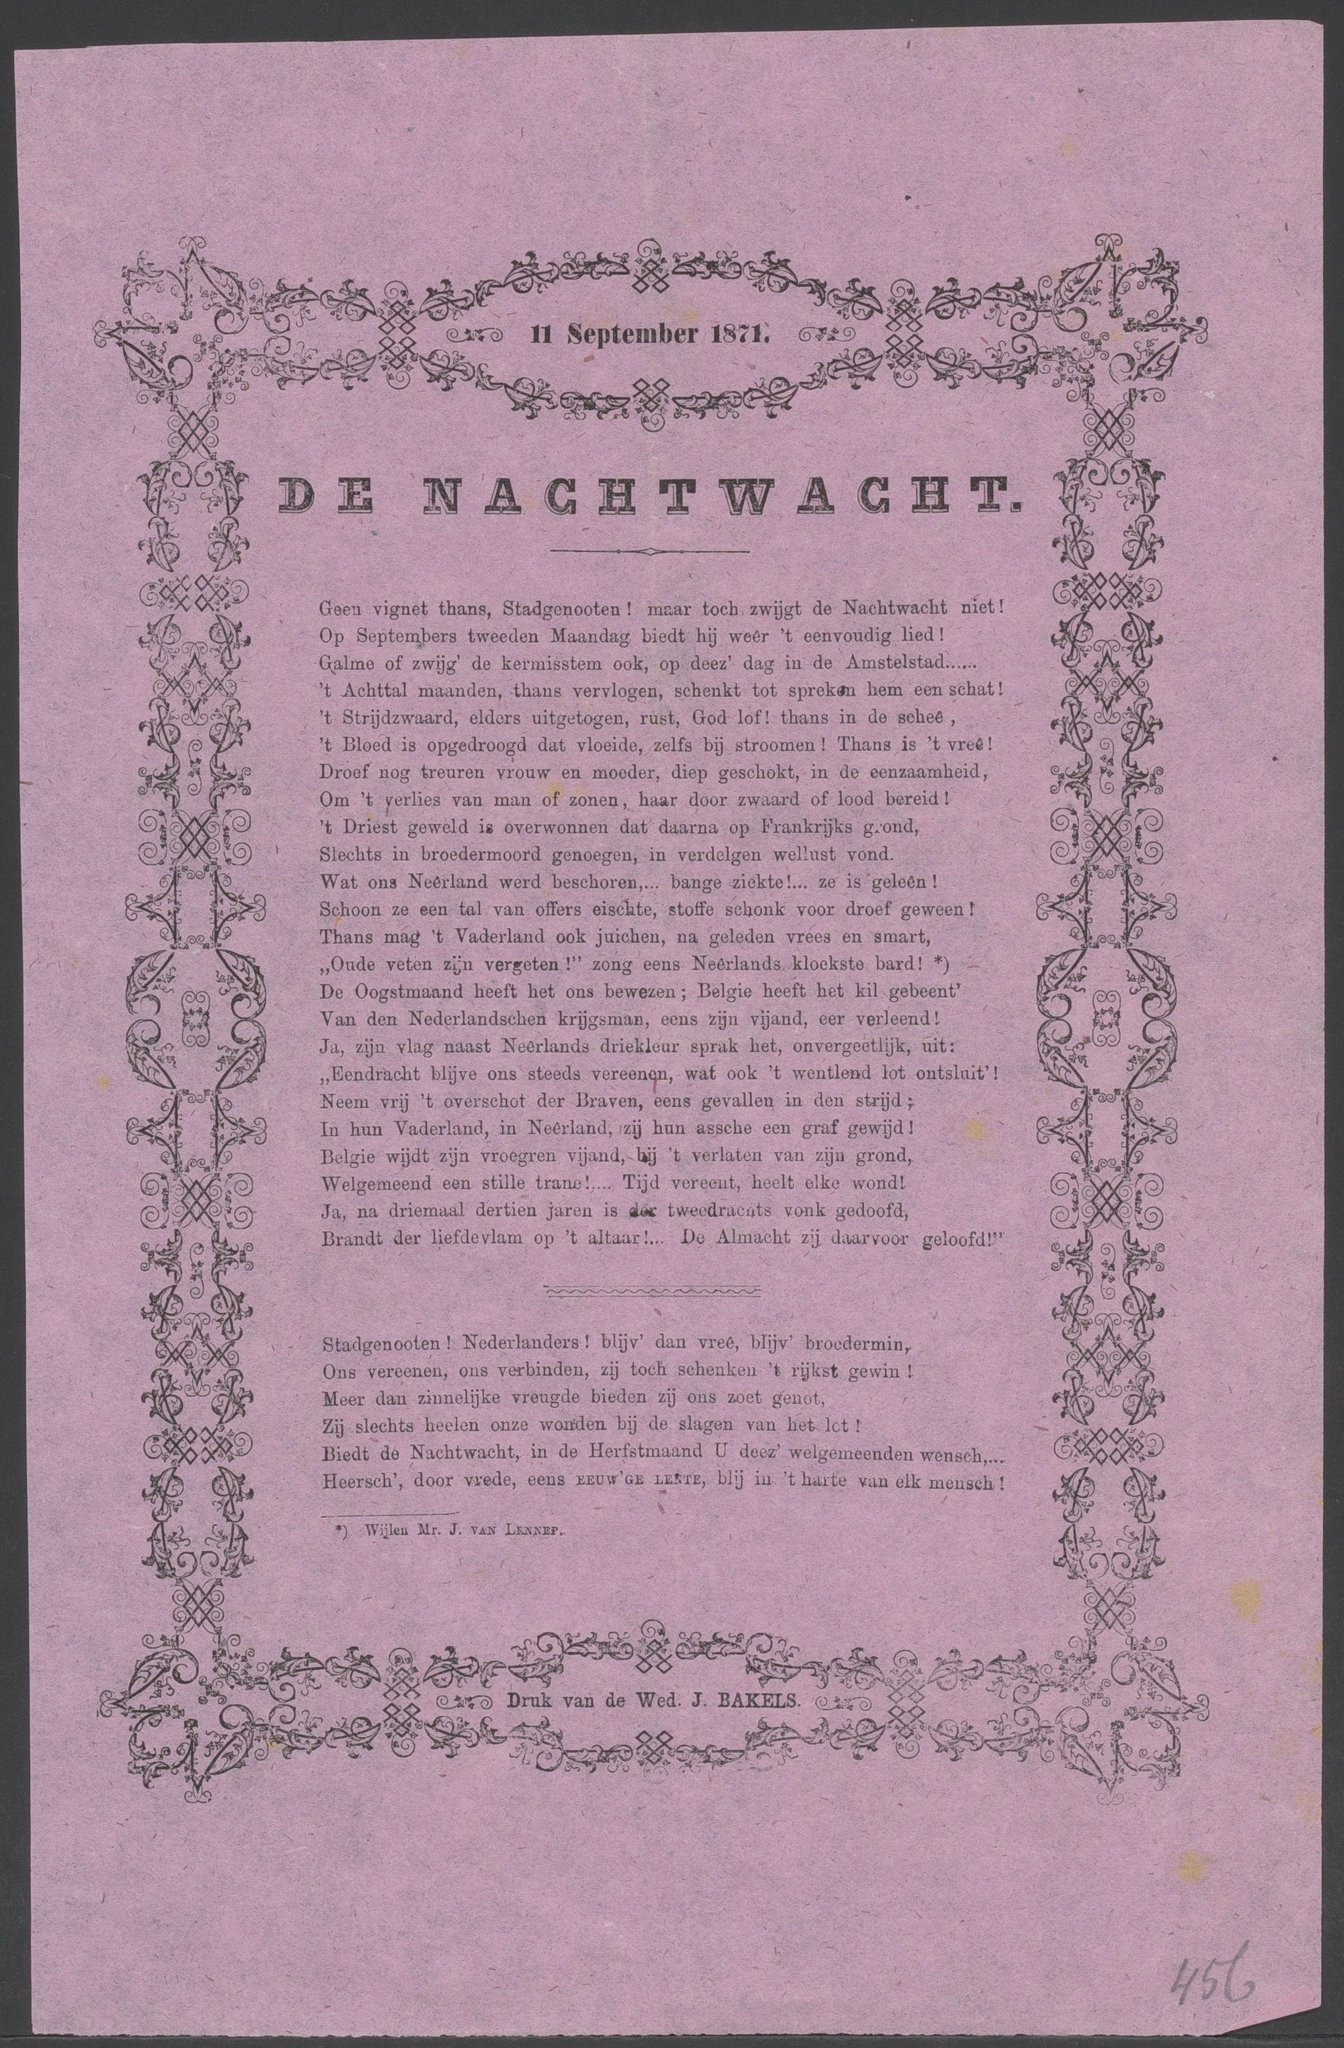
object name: print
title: Kermisprent van de Amsterdamse nachtwacht voor het jaar 1871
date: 1871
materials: paper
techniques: letterpress printing, engraving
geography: amsterdam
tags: night patrol, pleasure fair and circus, amsterdam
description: Kermisprent van de Amsterdamse nachtwacht (ratelwacht), 11 september 1871. Onderwerpsrubrieken binnen de Atlas Zeden en Gewoonten: Zeden en gewoonten in engeren zin, Volksleven, Volksbladen, Nieuwjaars- en Kerstwenschen, Amsterdam.